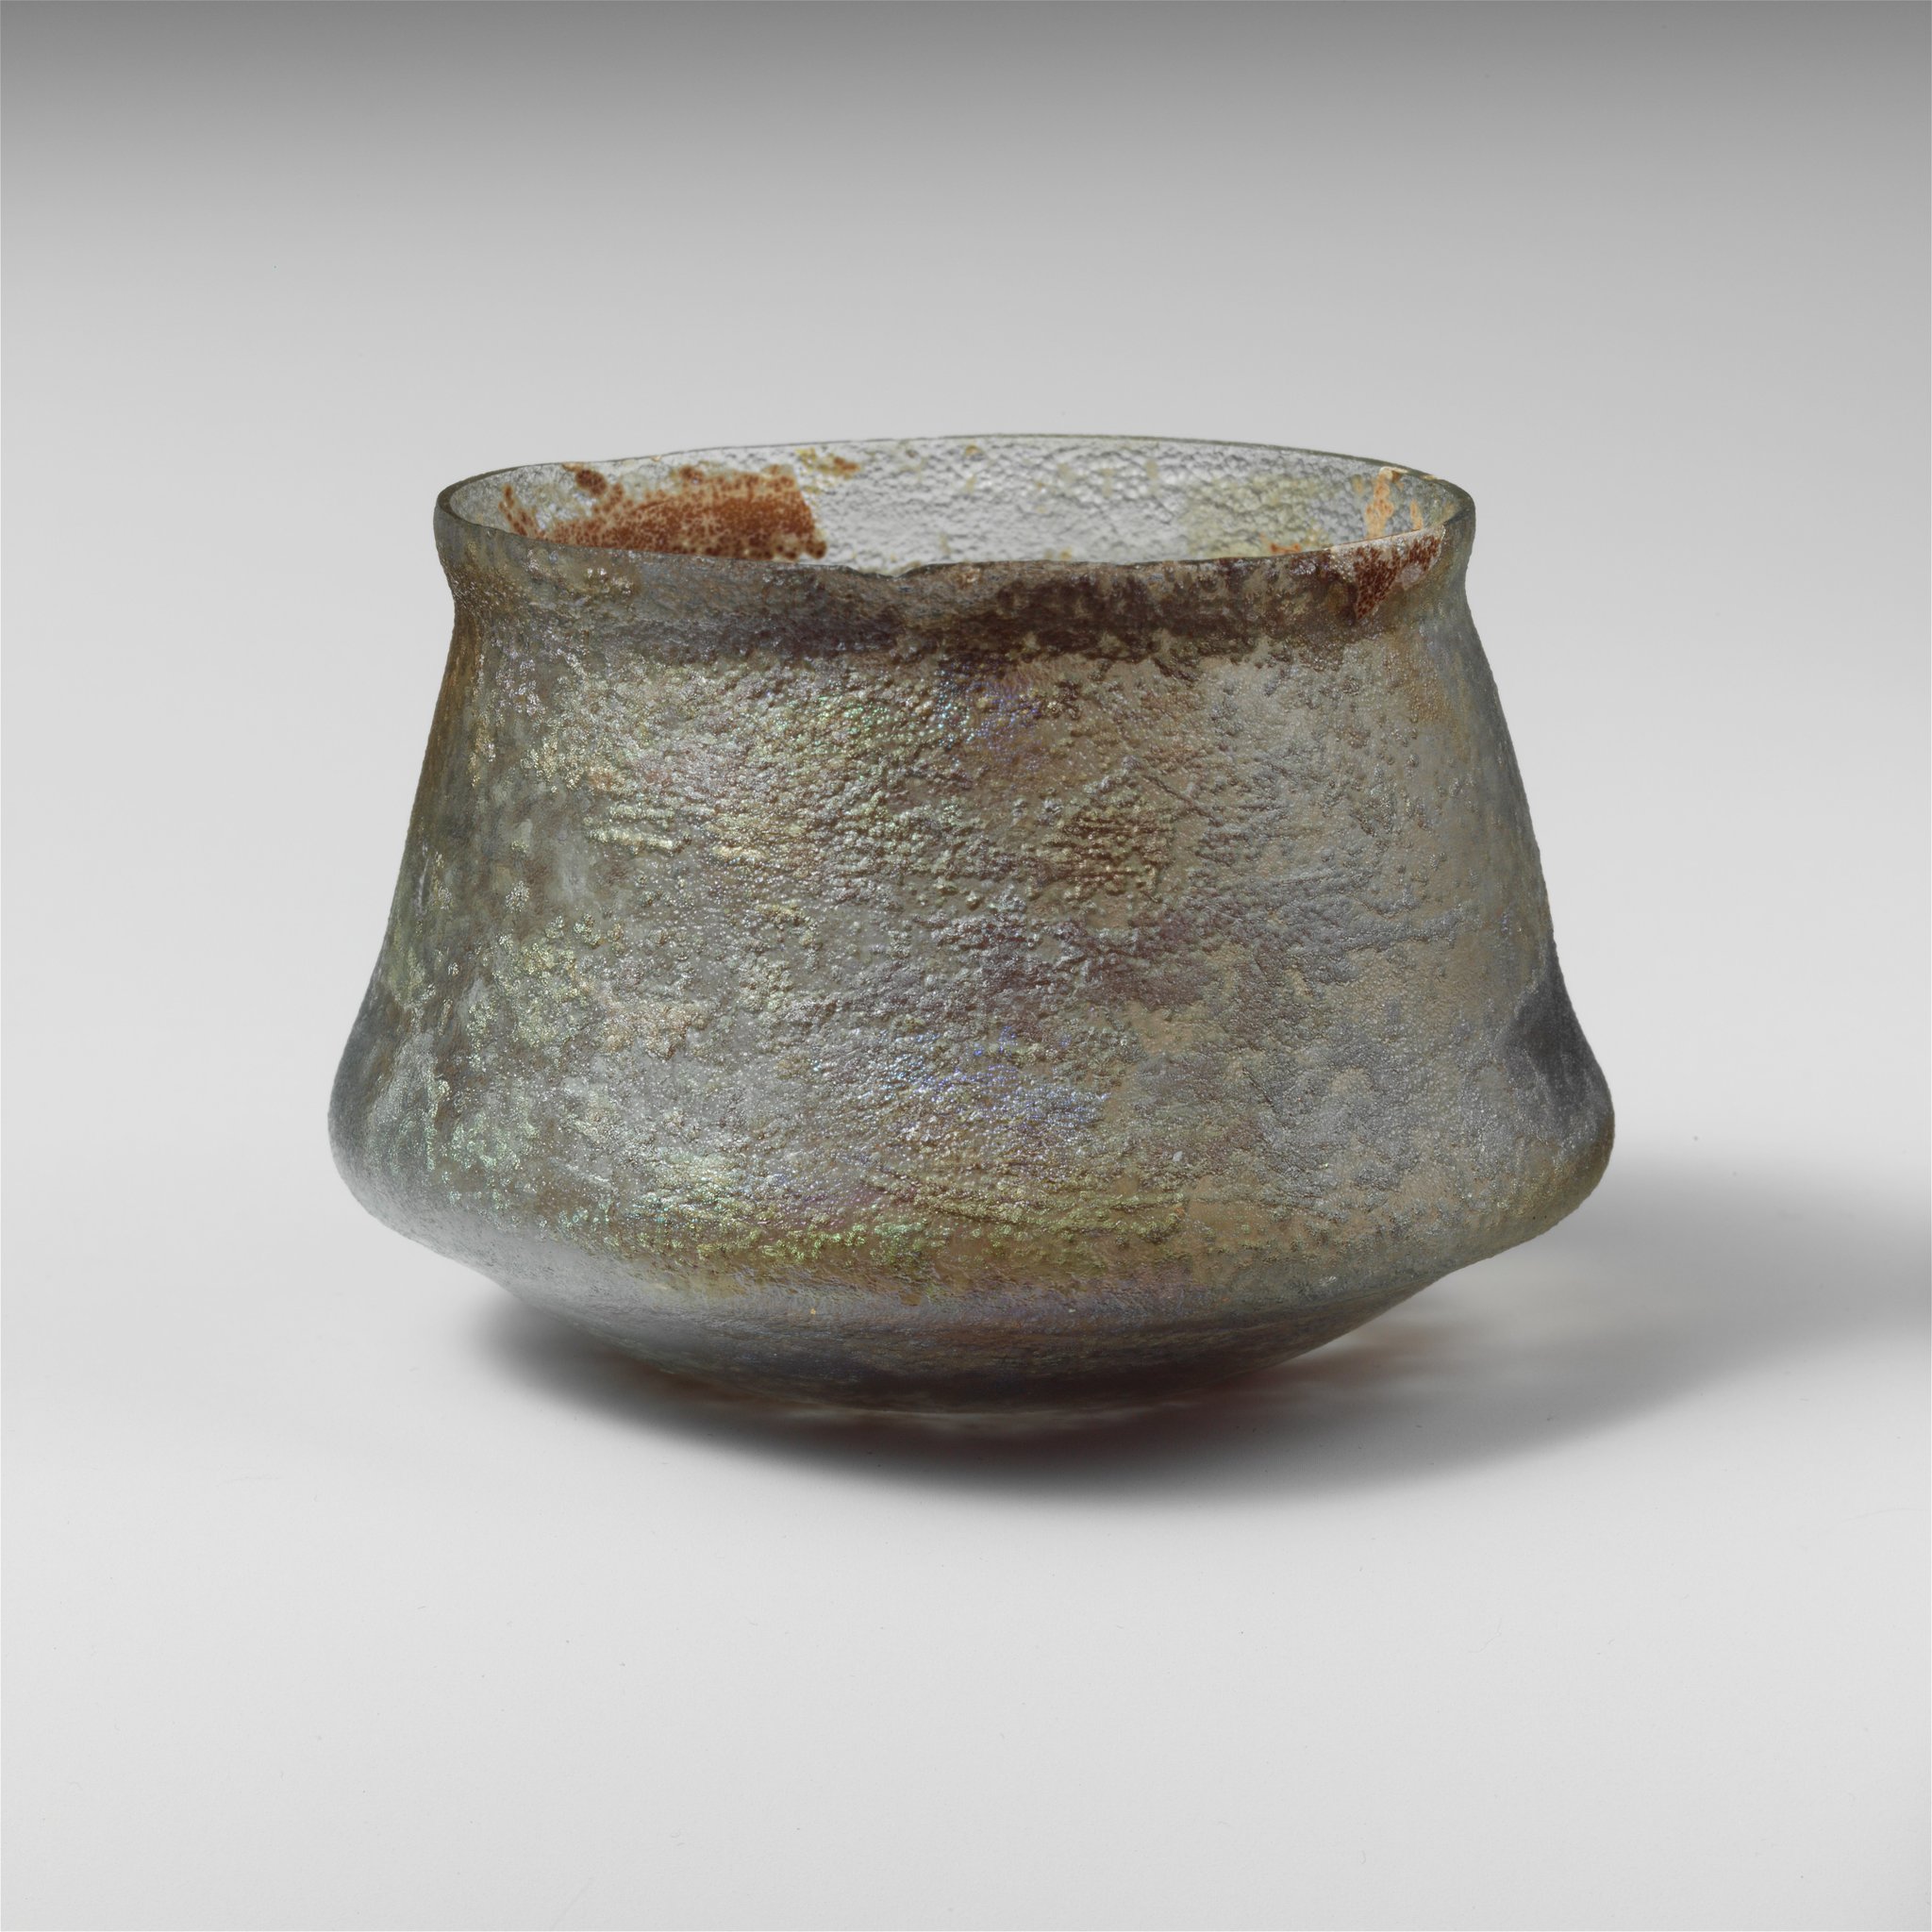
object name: cup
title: Glass cup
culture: roman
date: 101-300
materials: glass